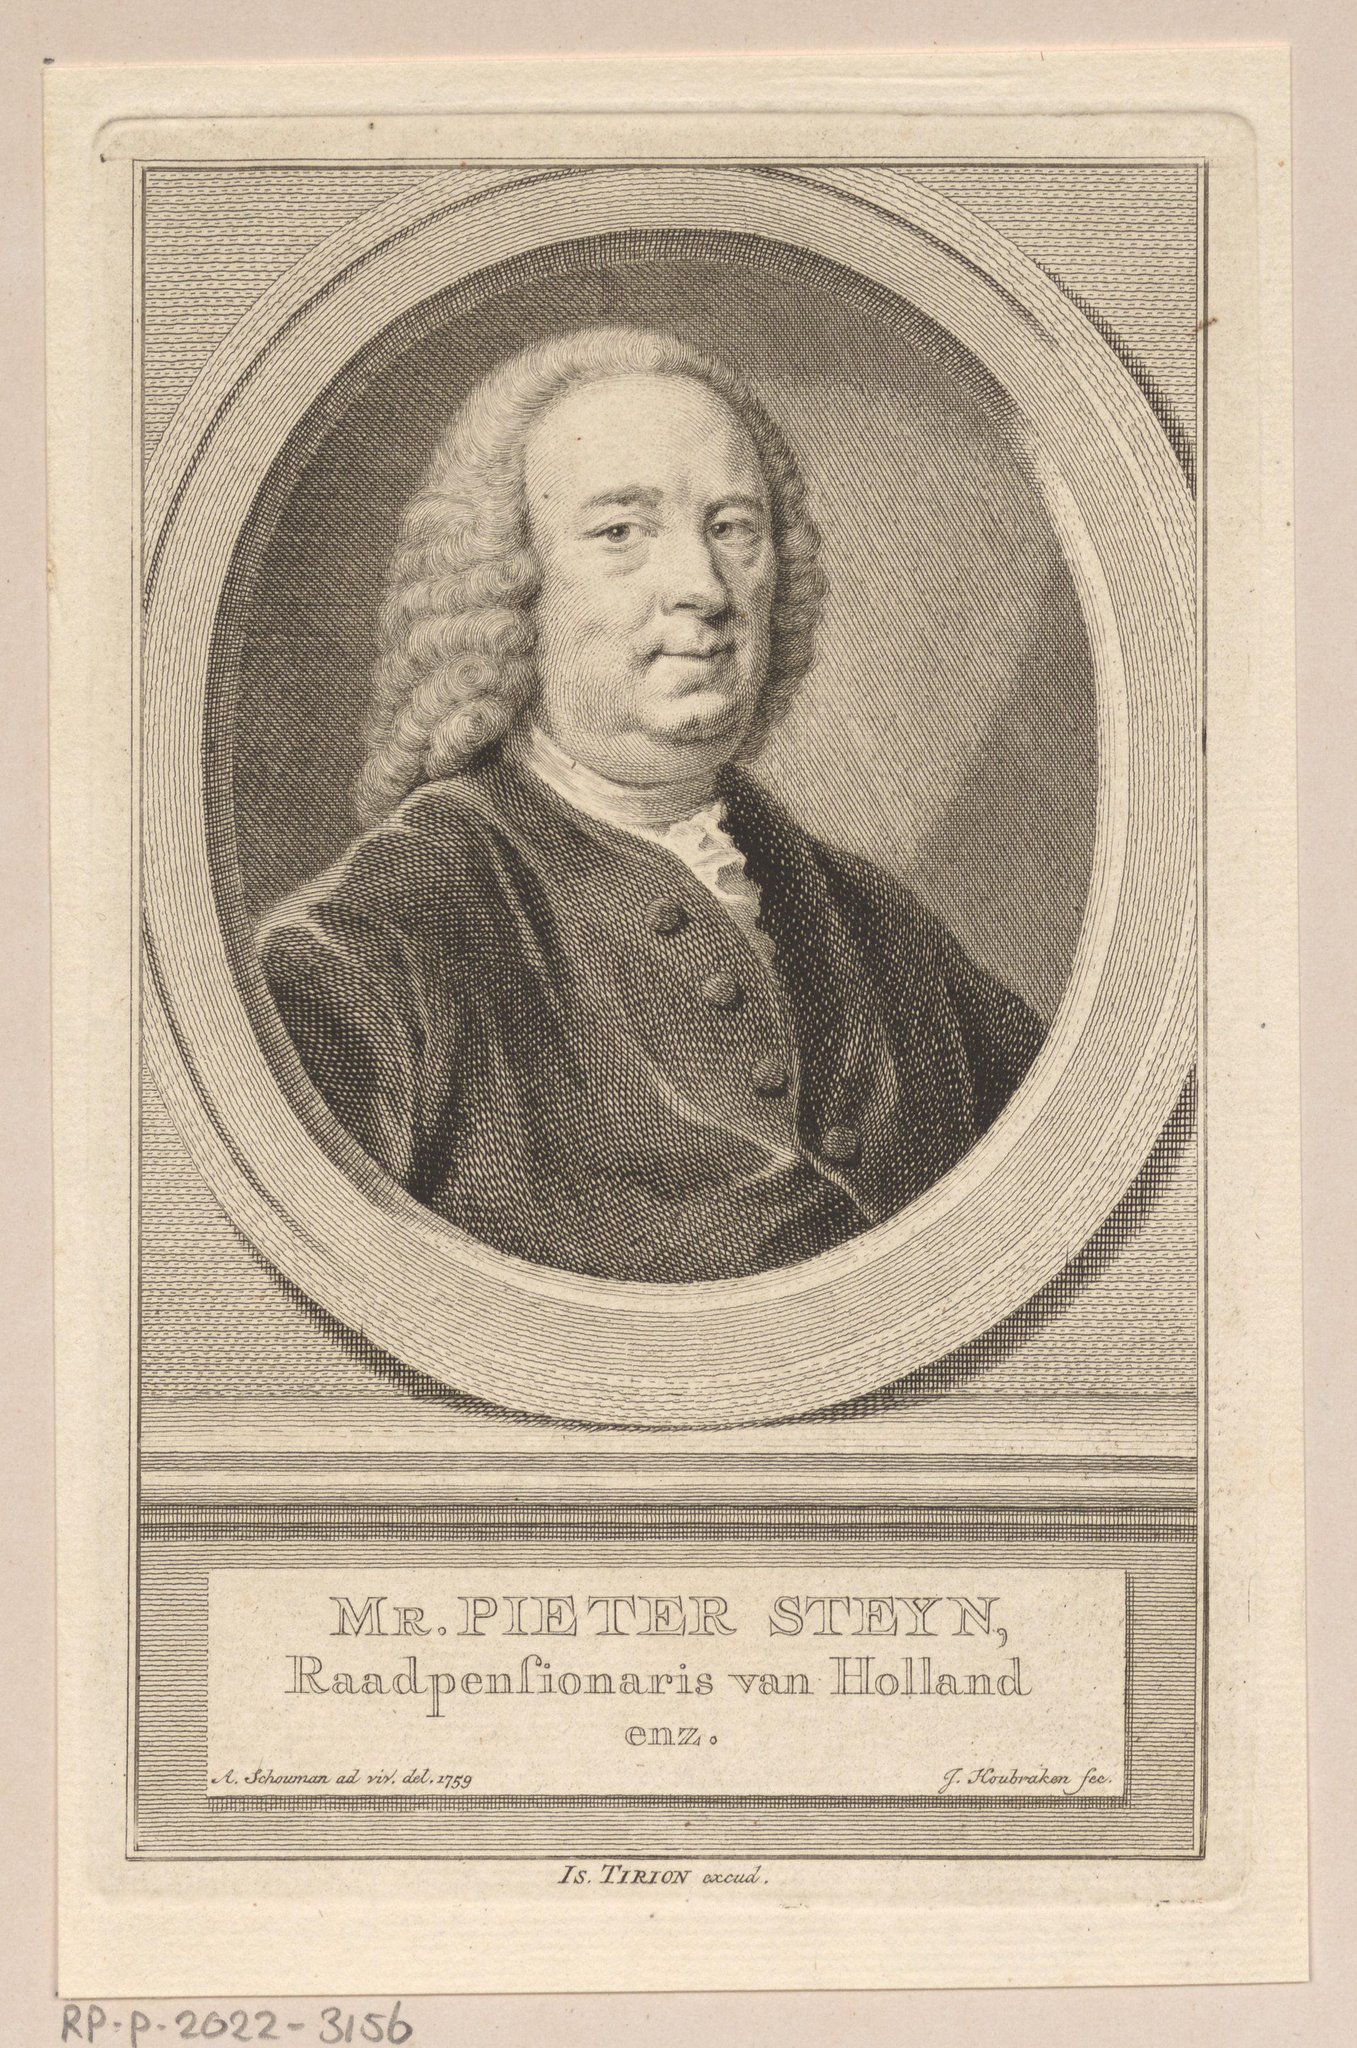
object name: print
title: Portret van Pieter Steijn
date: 1759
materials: paper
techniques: engraving, etching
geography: amsterdam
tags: haarlem, the hague, historical persons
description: Prent waarschijnlijk uit: Wagenaar, Jan. Vaderlandsche historie, vervattende de geschiedenissen der nu Vereenigde Nederlanden, inzonderheid die van Holland (...). Amsterdam: Isaak Tirion, 1759, dl. 20.